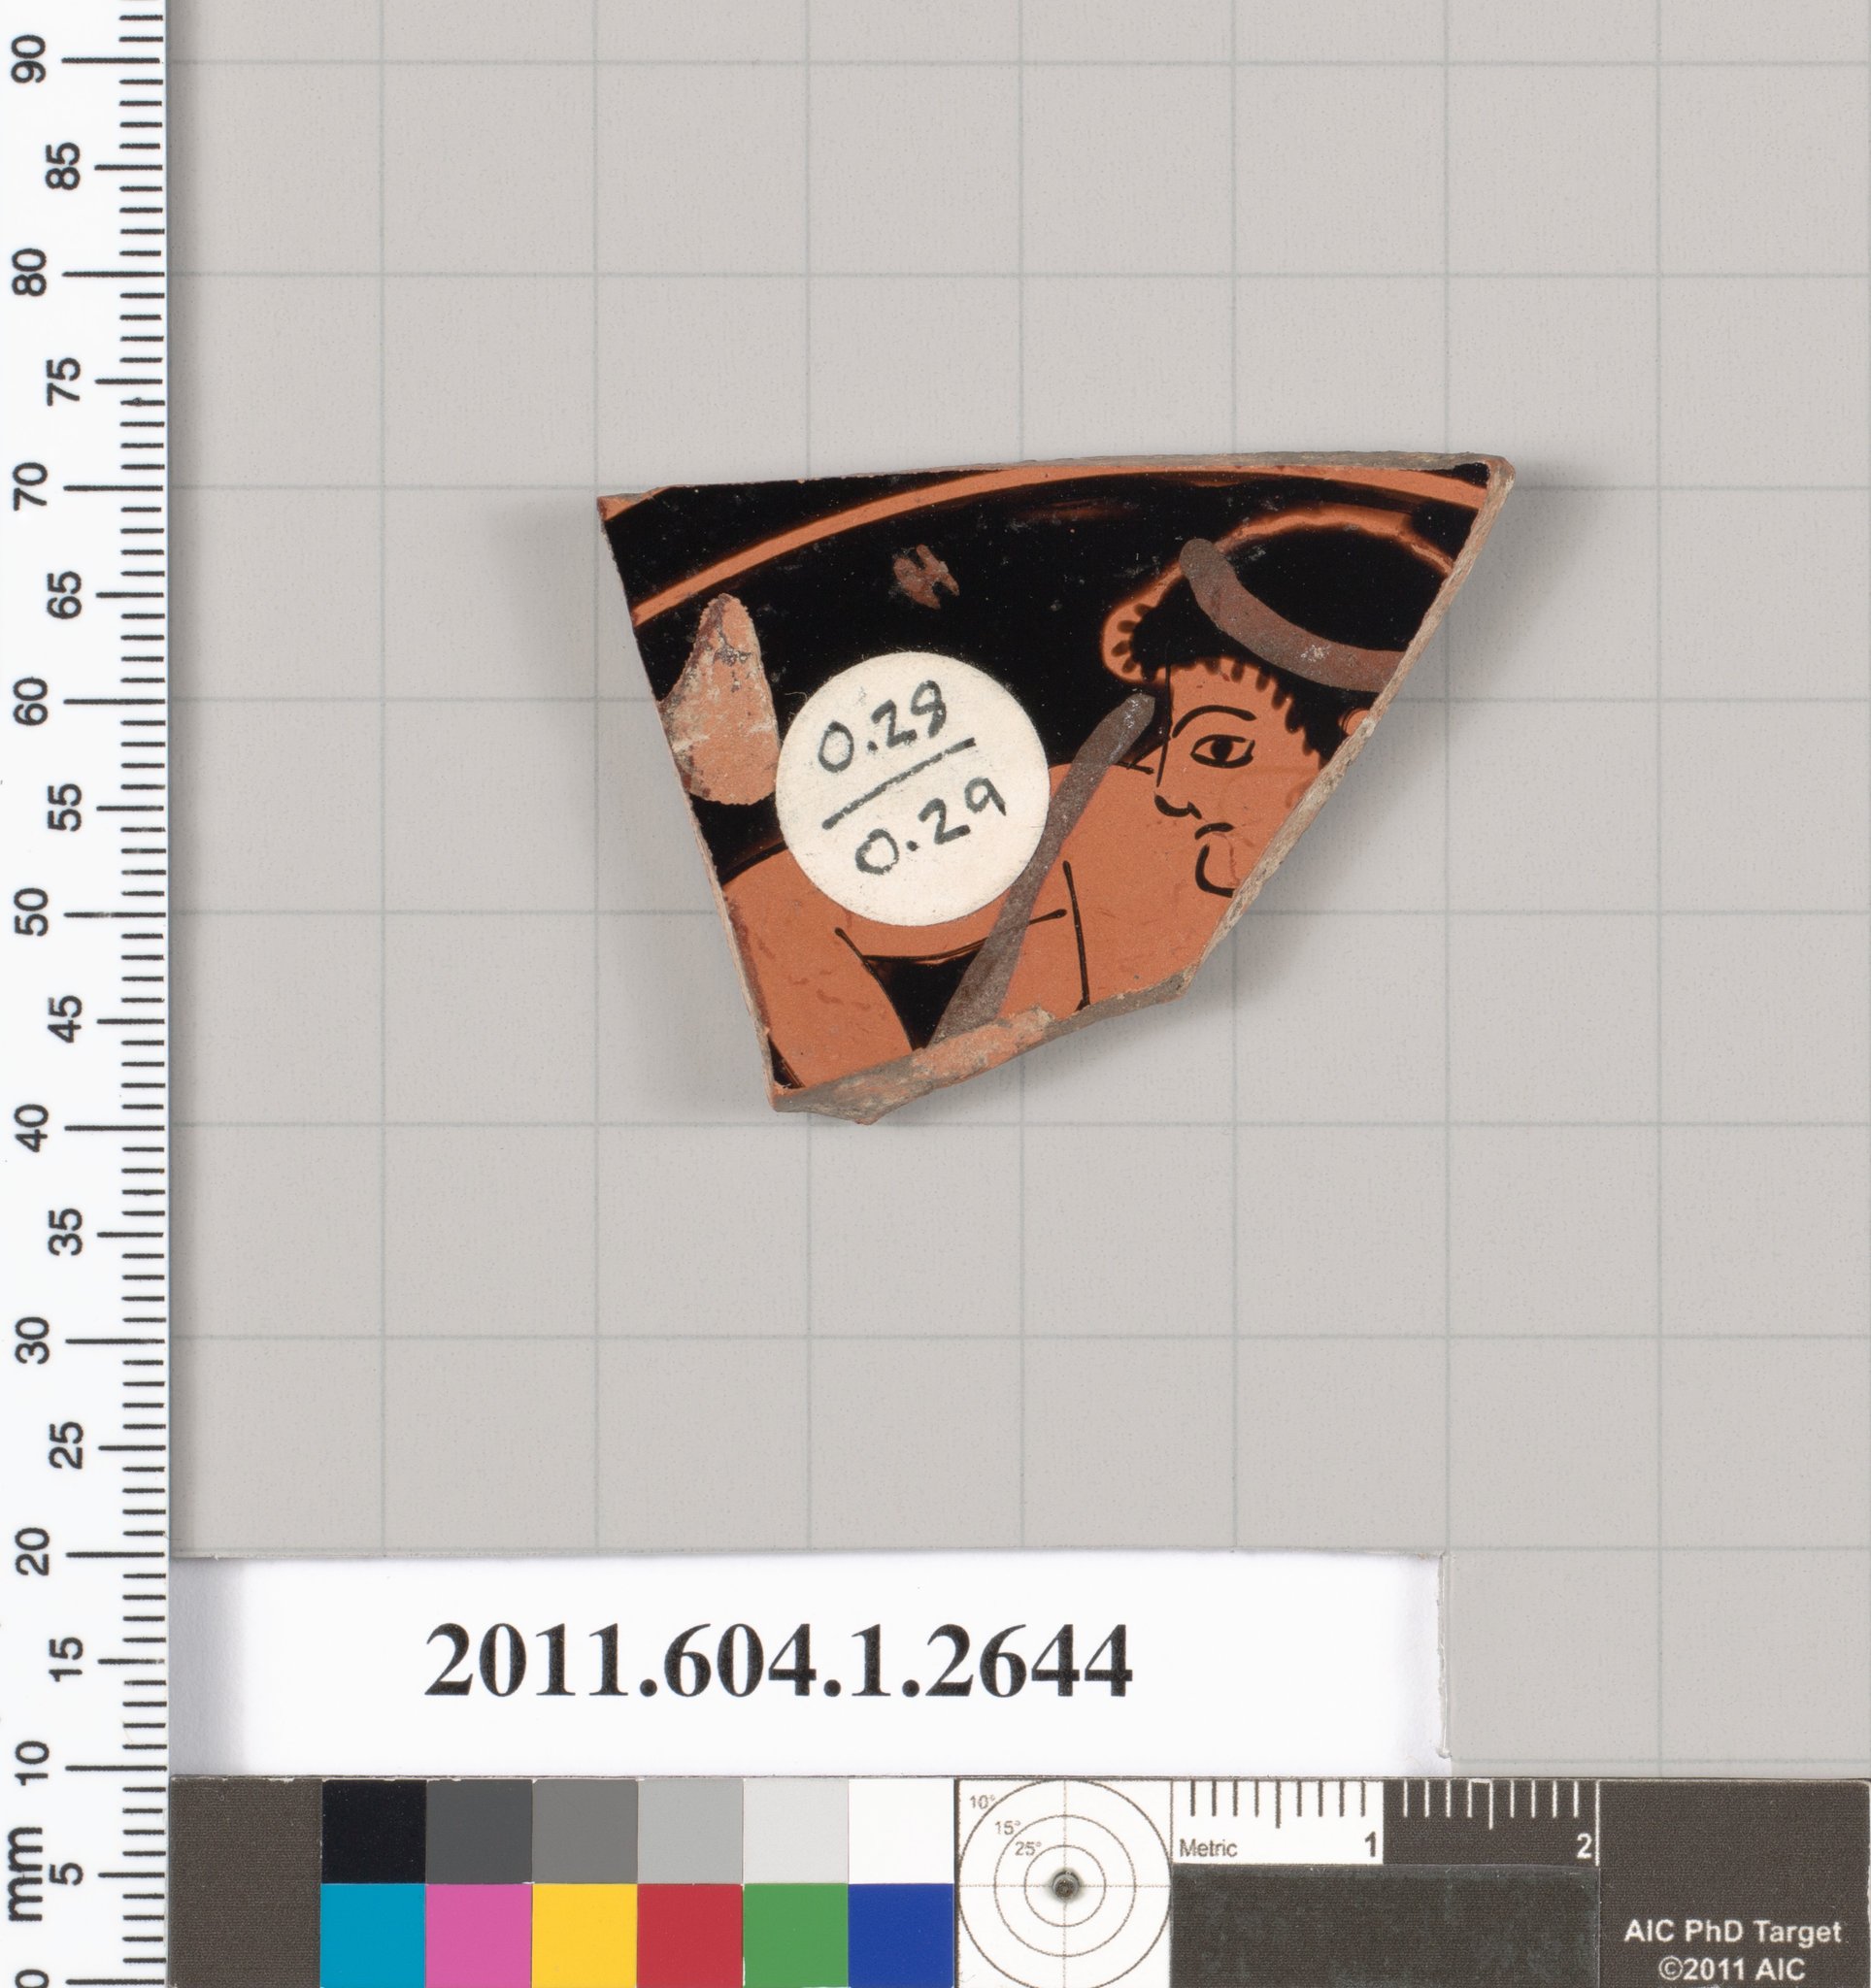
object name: kylix fragment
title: Terracotta fragment of a kylix (drinking cup)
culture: greek, attic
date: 520-500 BCE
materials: terracotta